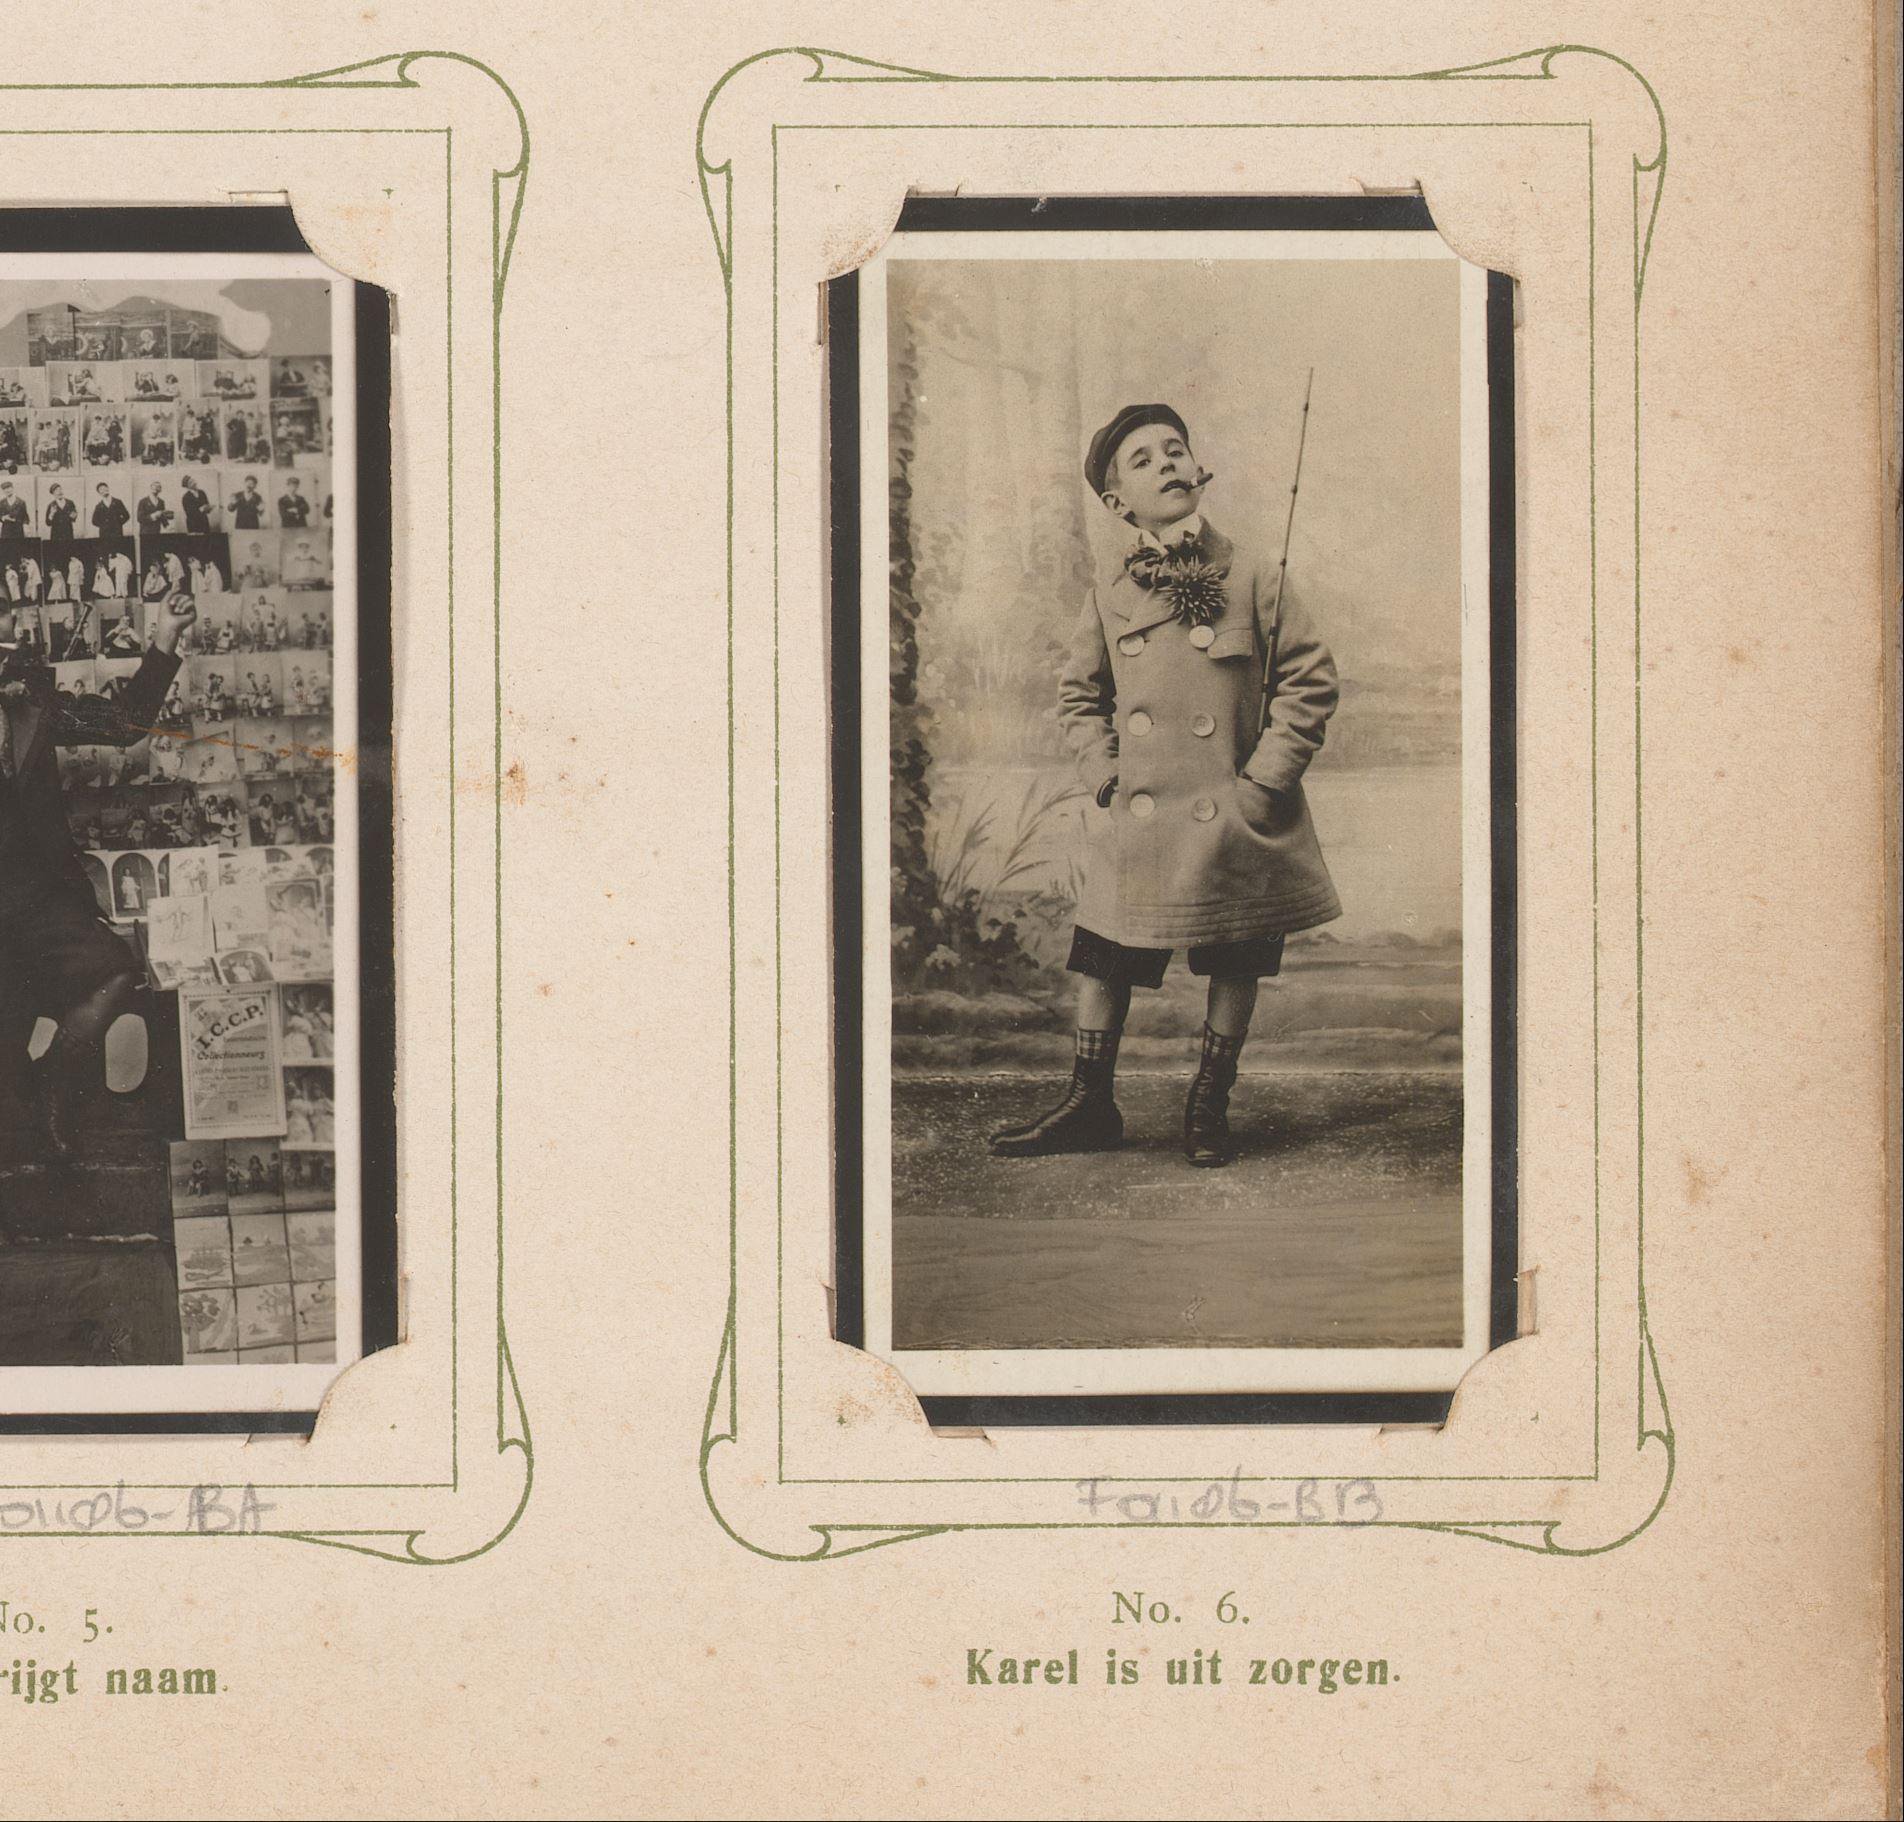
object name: photograph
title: Jongen met sigaar en wandelstok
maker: Anonymous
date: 1904-1905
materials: photographic support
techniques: gelatin silver print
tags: cigar, boy (child between toddler and youth)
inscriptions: inscription: ‘No. 6./ Karel is uit zorgen.’